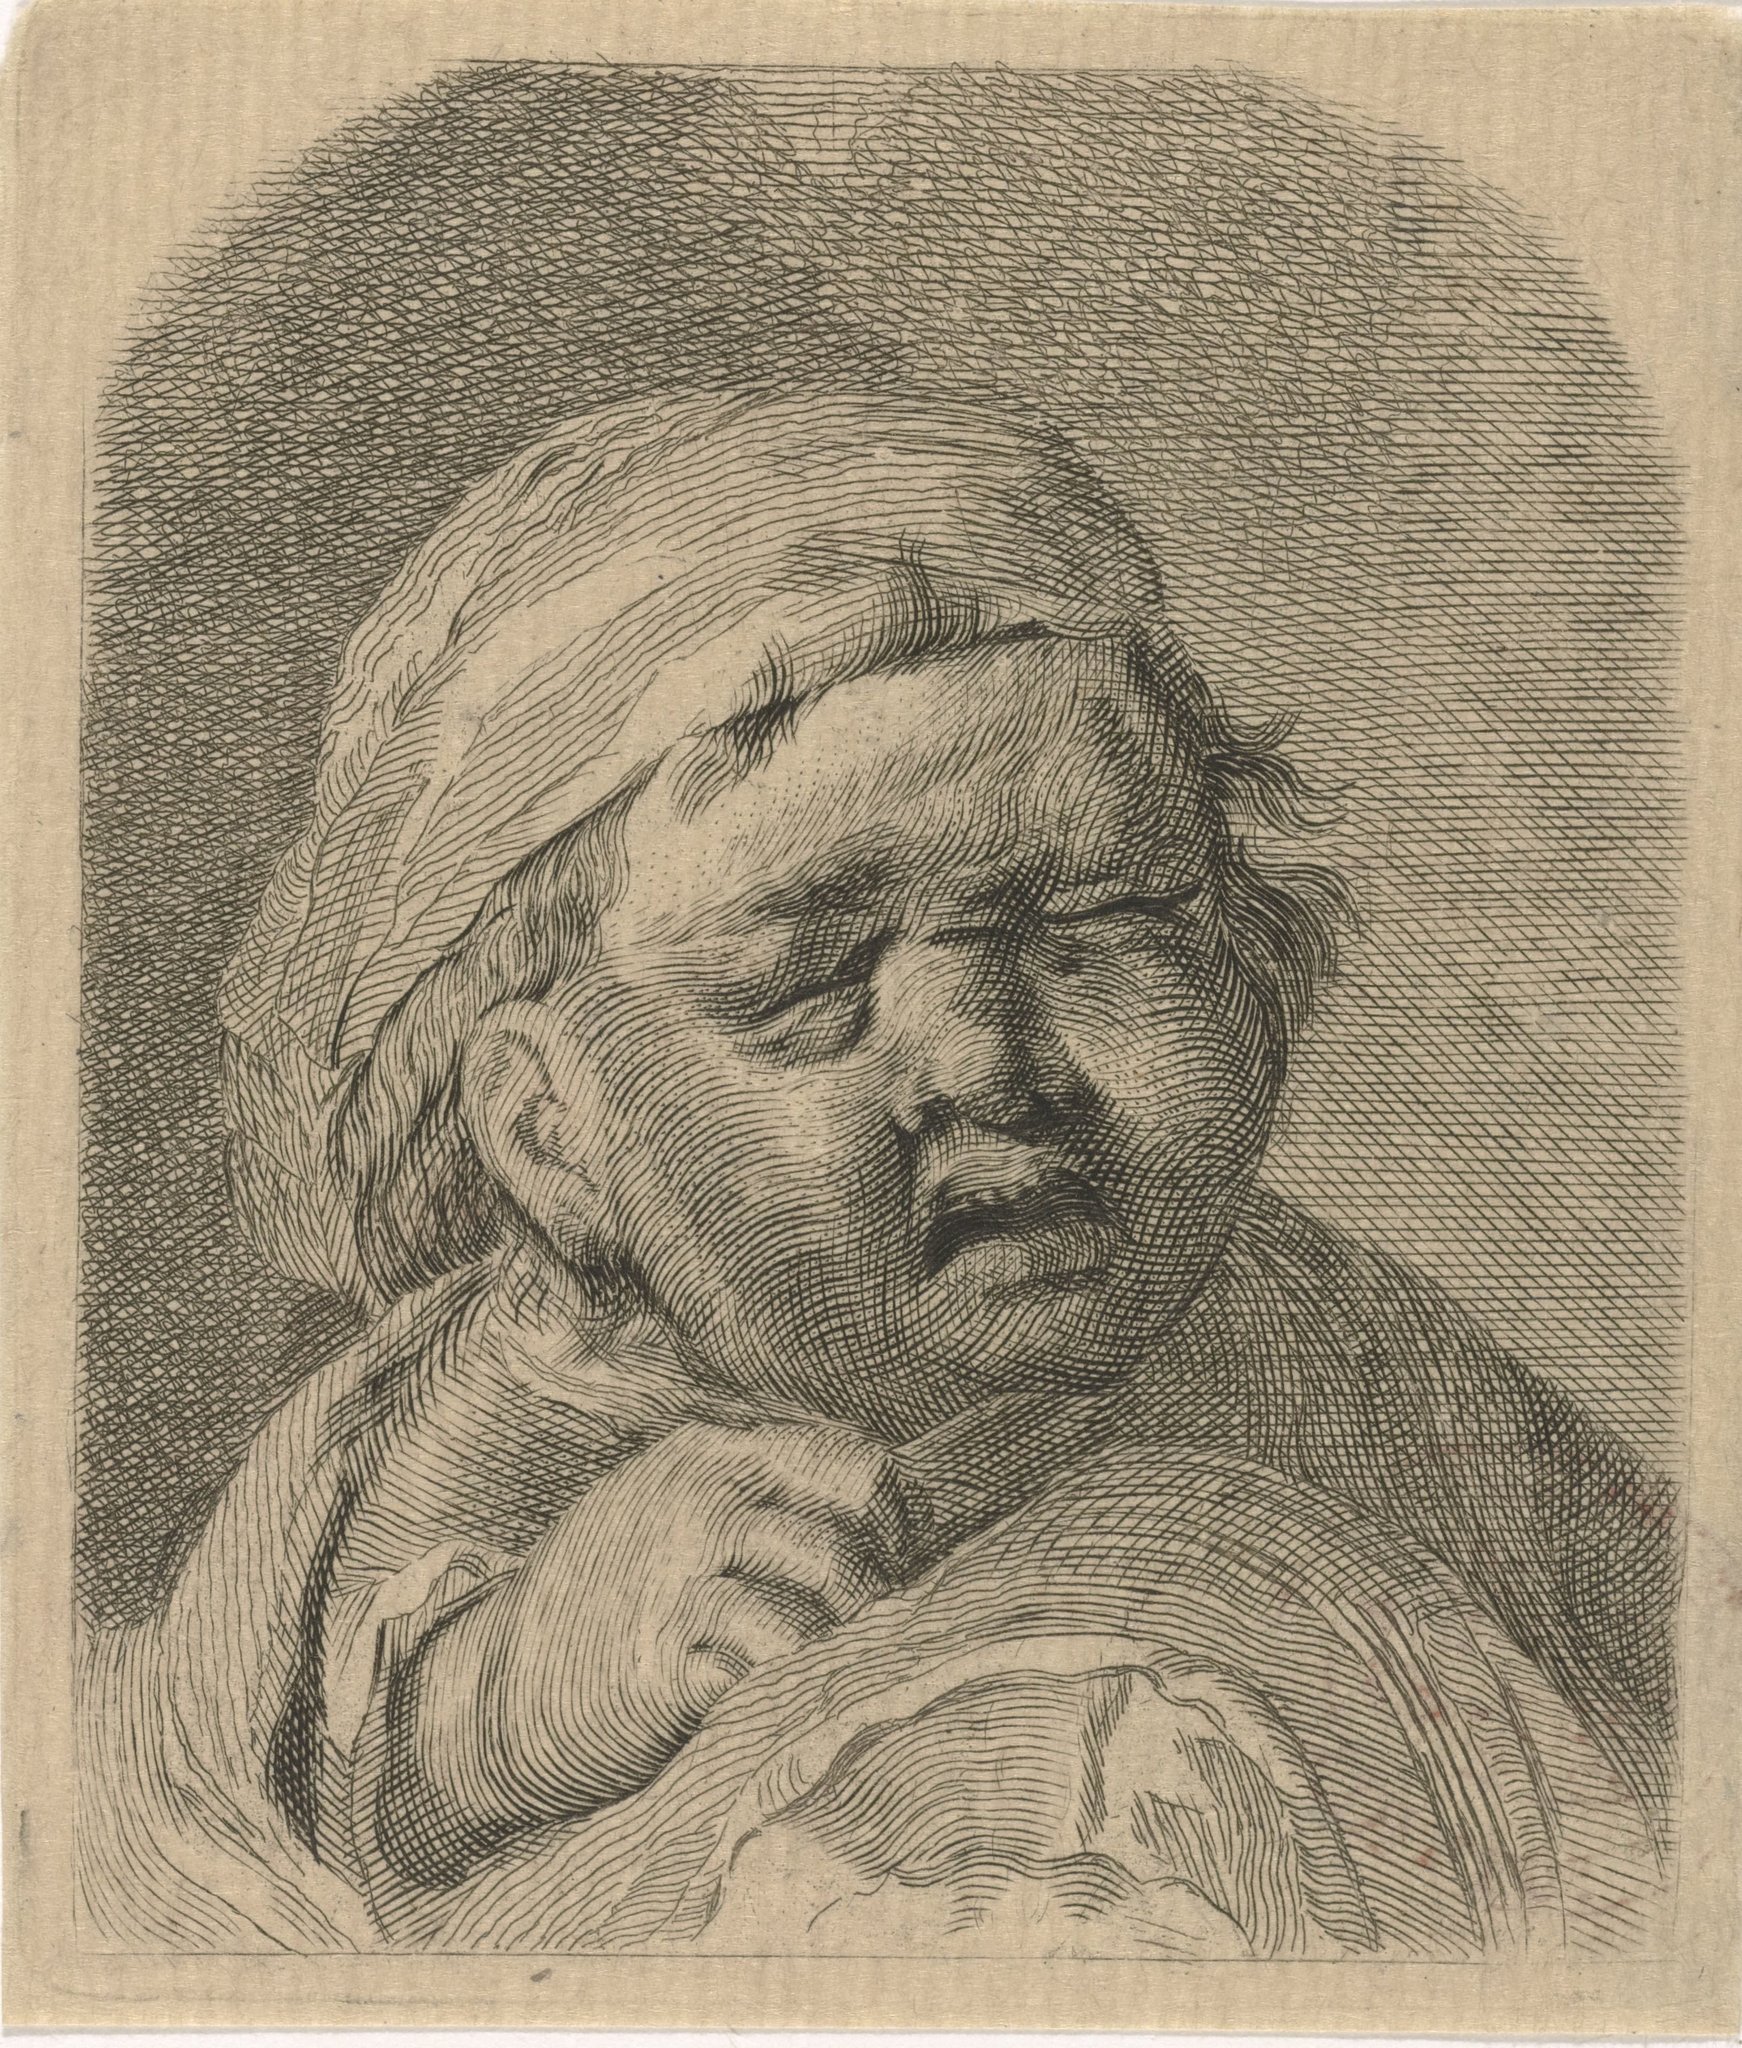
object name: print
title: Huilend kind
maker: pieter de mare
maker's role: print maker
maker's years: 1758-1796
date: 1768-1796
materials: paper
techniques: engraving, etching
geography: leiden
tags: child (+ being sad, suffering, sorrowing)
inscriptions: collector's mark: Lugt 240